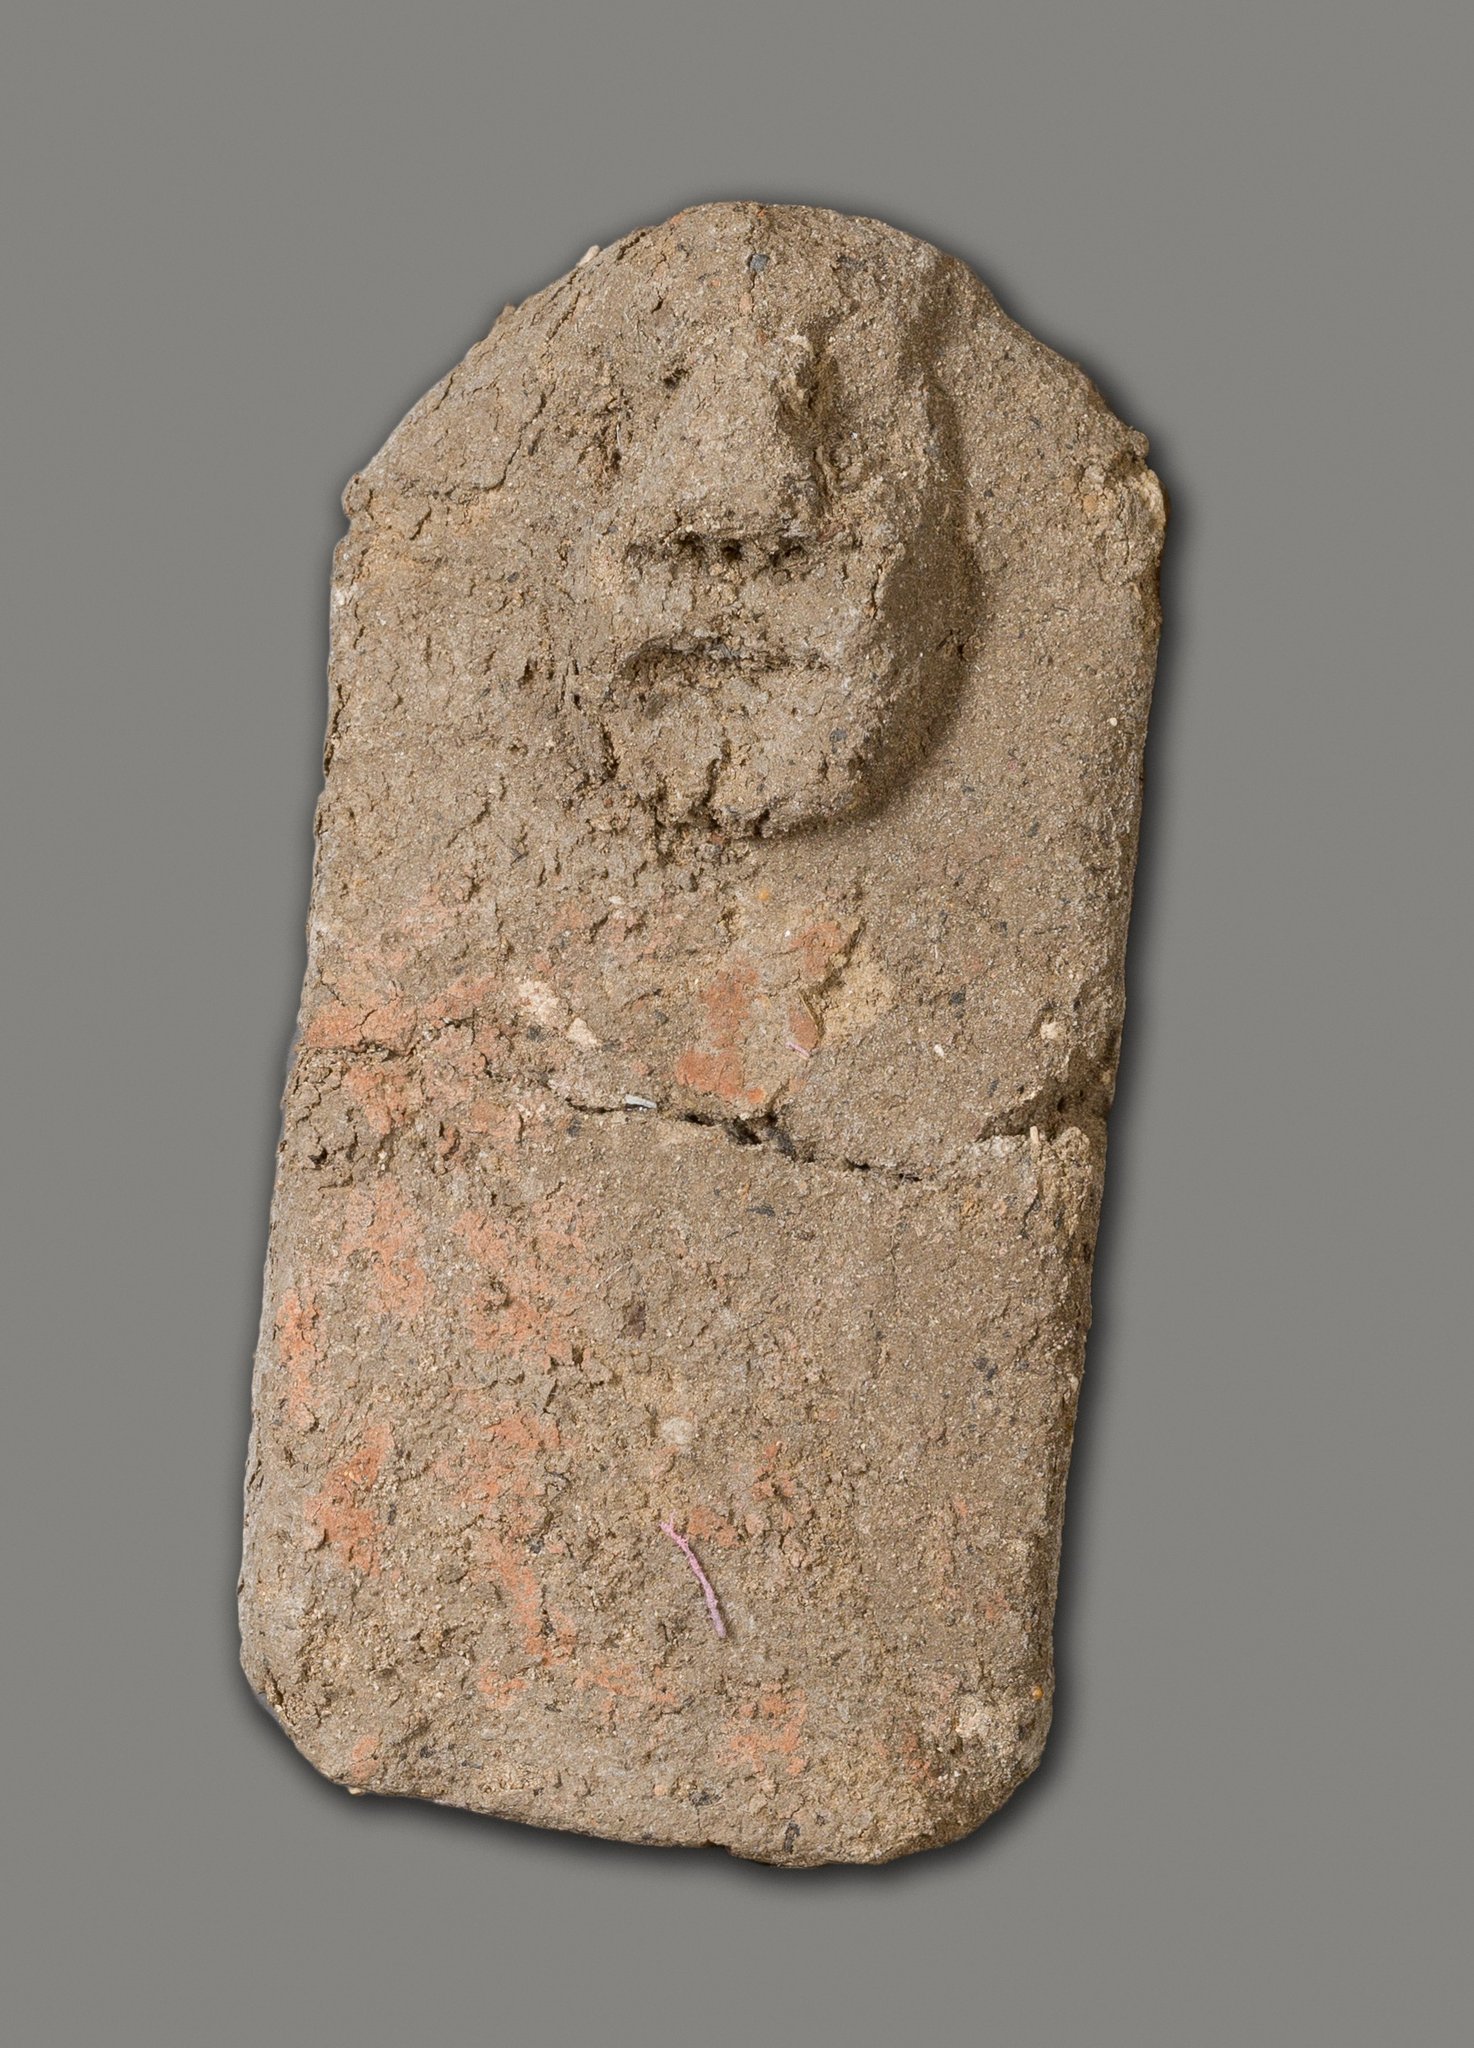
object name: figure, magical, execration, tablet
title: Magical Figure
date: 1802-1550 BCE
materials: clay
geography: egypt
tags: faces